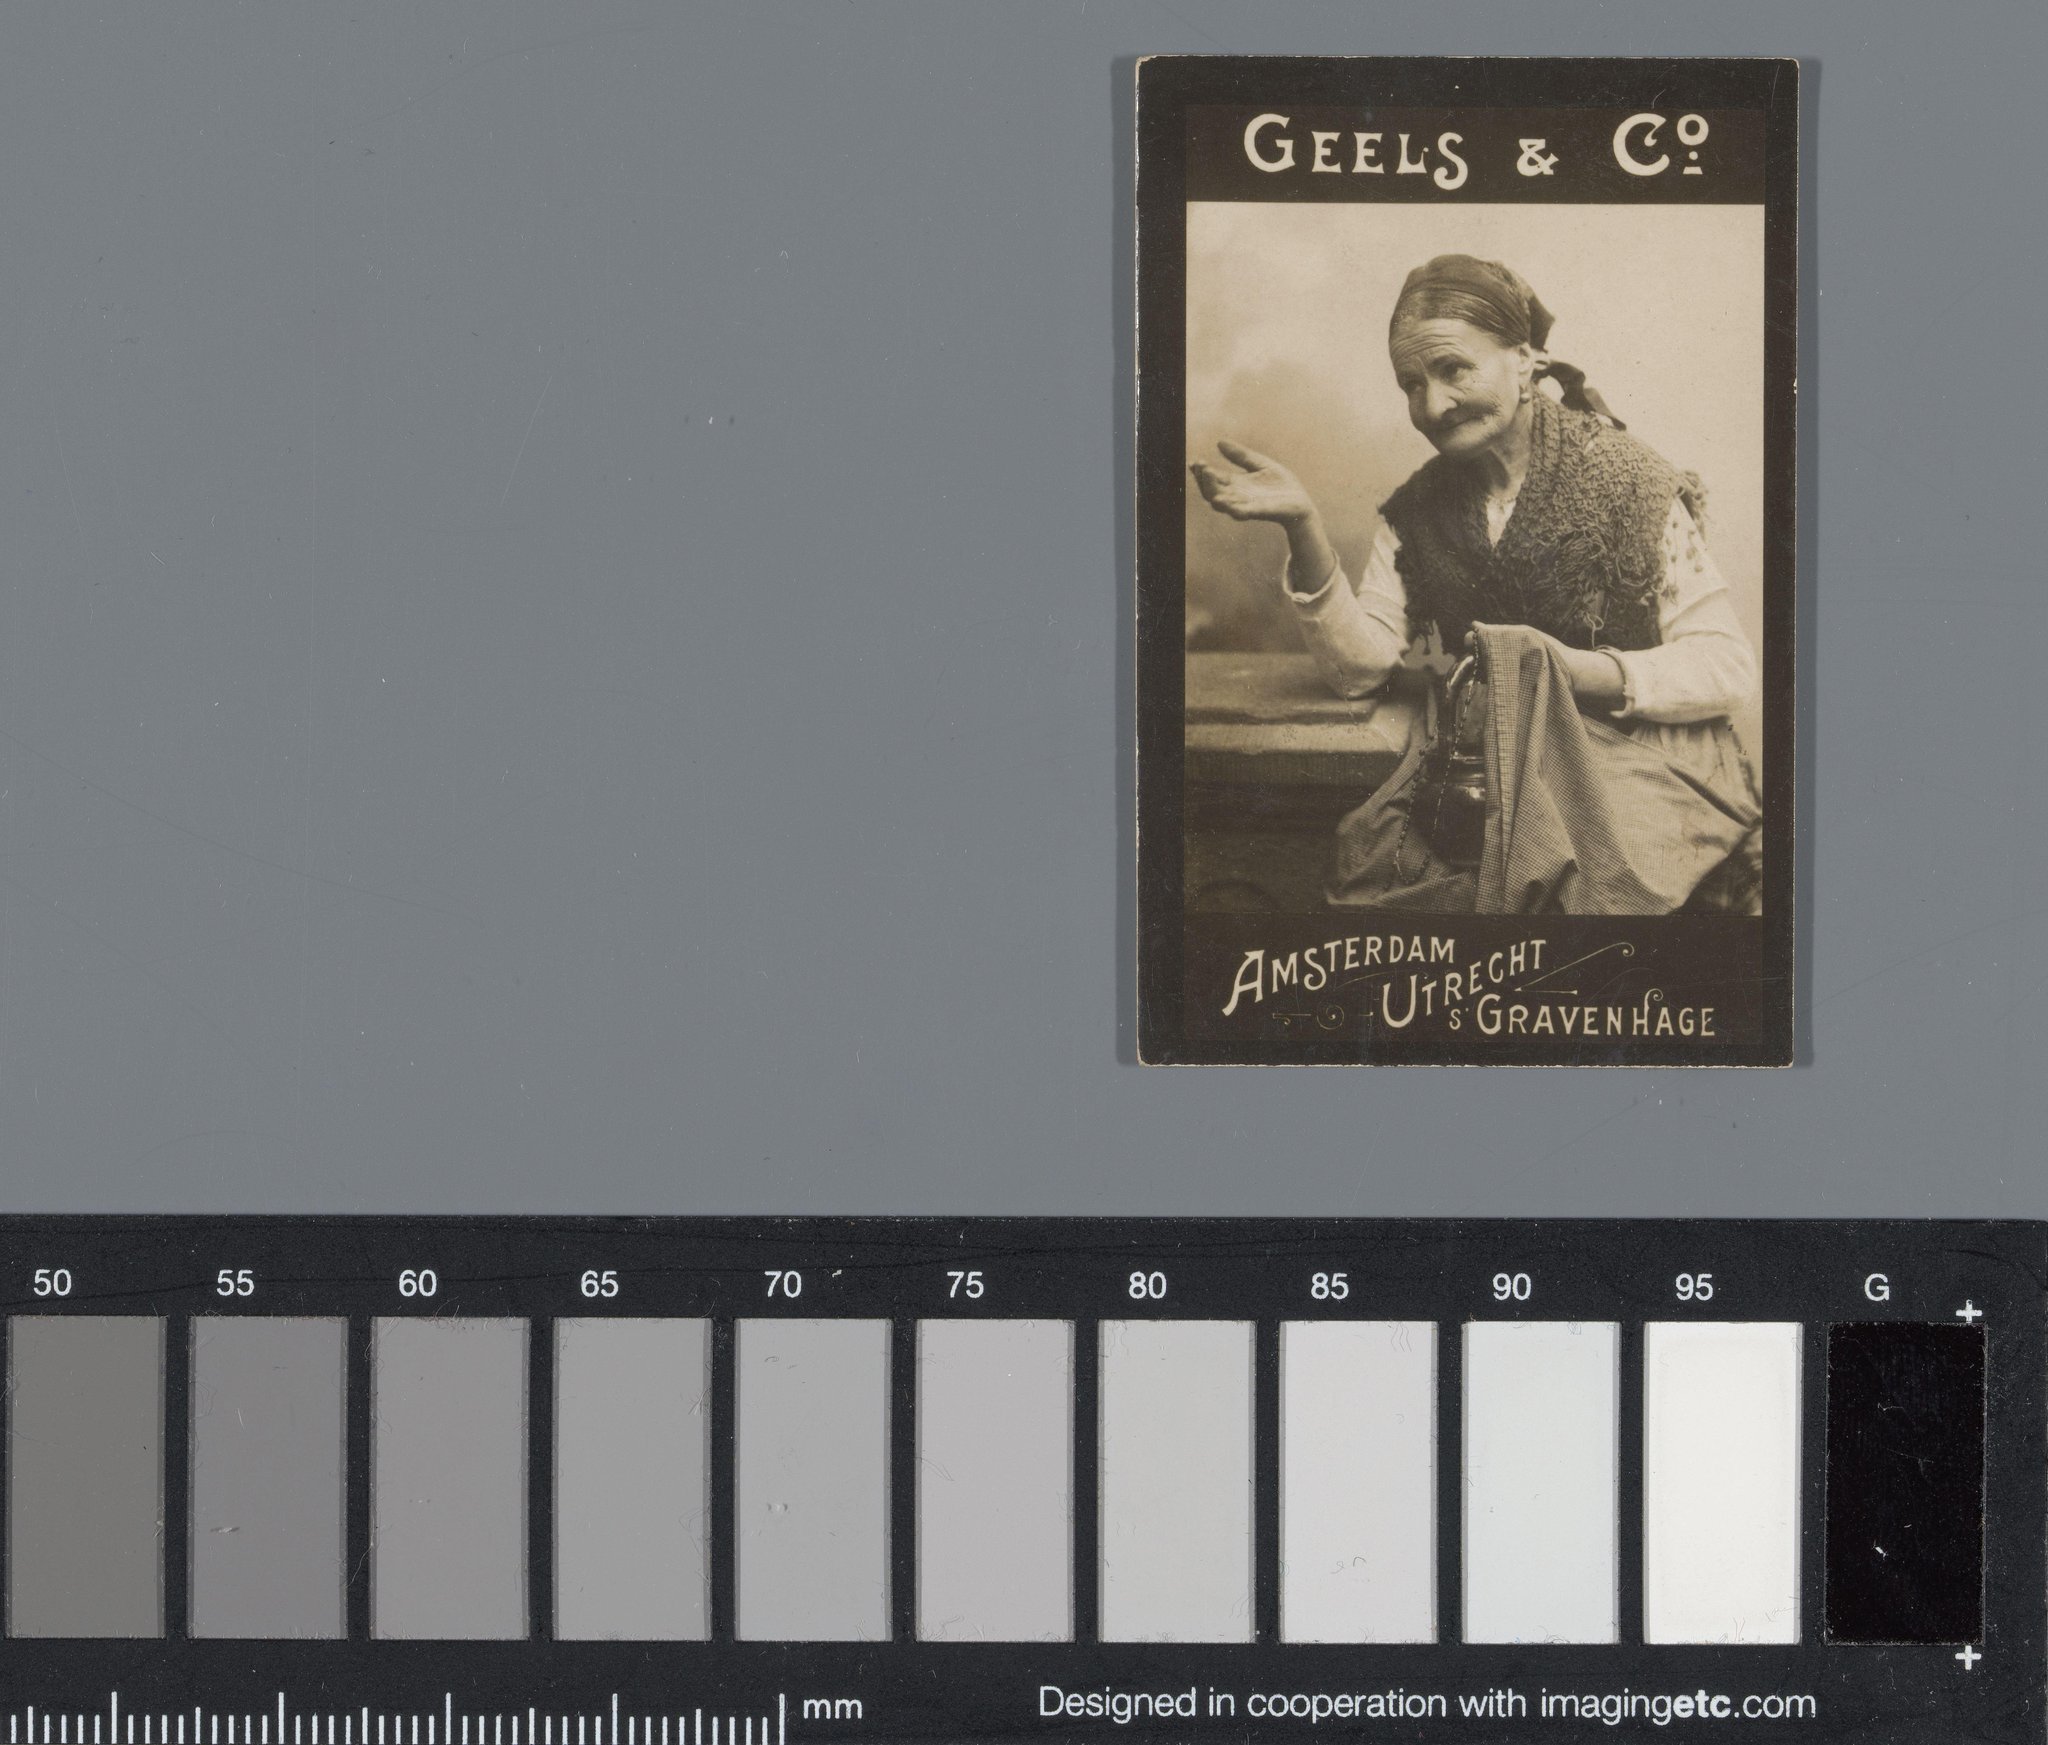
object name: photograph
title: Onbekende bejaarde vrouw met een theepot, reclame voor Geels & Co.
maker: Anonymous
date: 1895-1910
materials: paper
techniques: gelatin silver print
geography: netherlands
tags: old woman, netherlands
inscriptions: inscription: ‘Amsterdam/ Utrecht/ s Gravenhage’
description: Dergelijke foto's stonden bekend als 'zwartjes'. Men verkreeg ze bij aanschaf van bepaalde merken thee, cacao, sigaretten, beschuit, etc. om te verzamelen. Er waren speciaal voor de 'zwartjes' verzamelalbums in omloop.